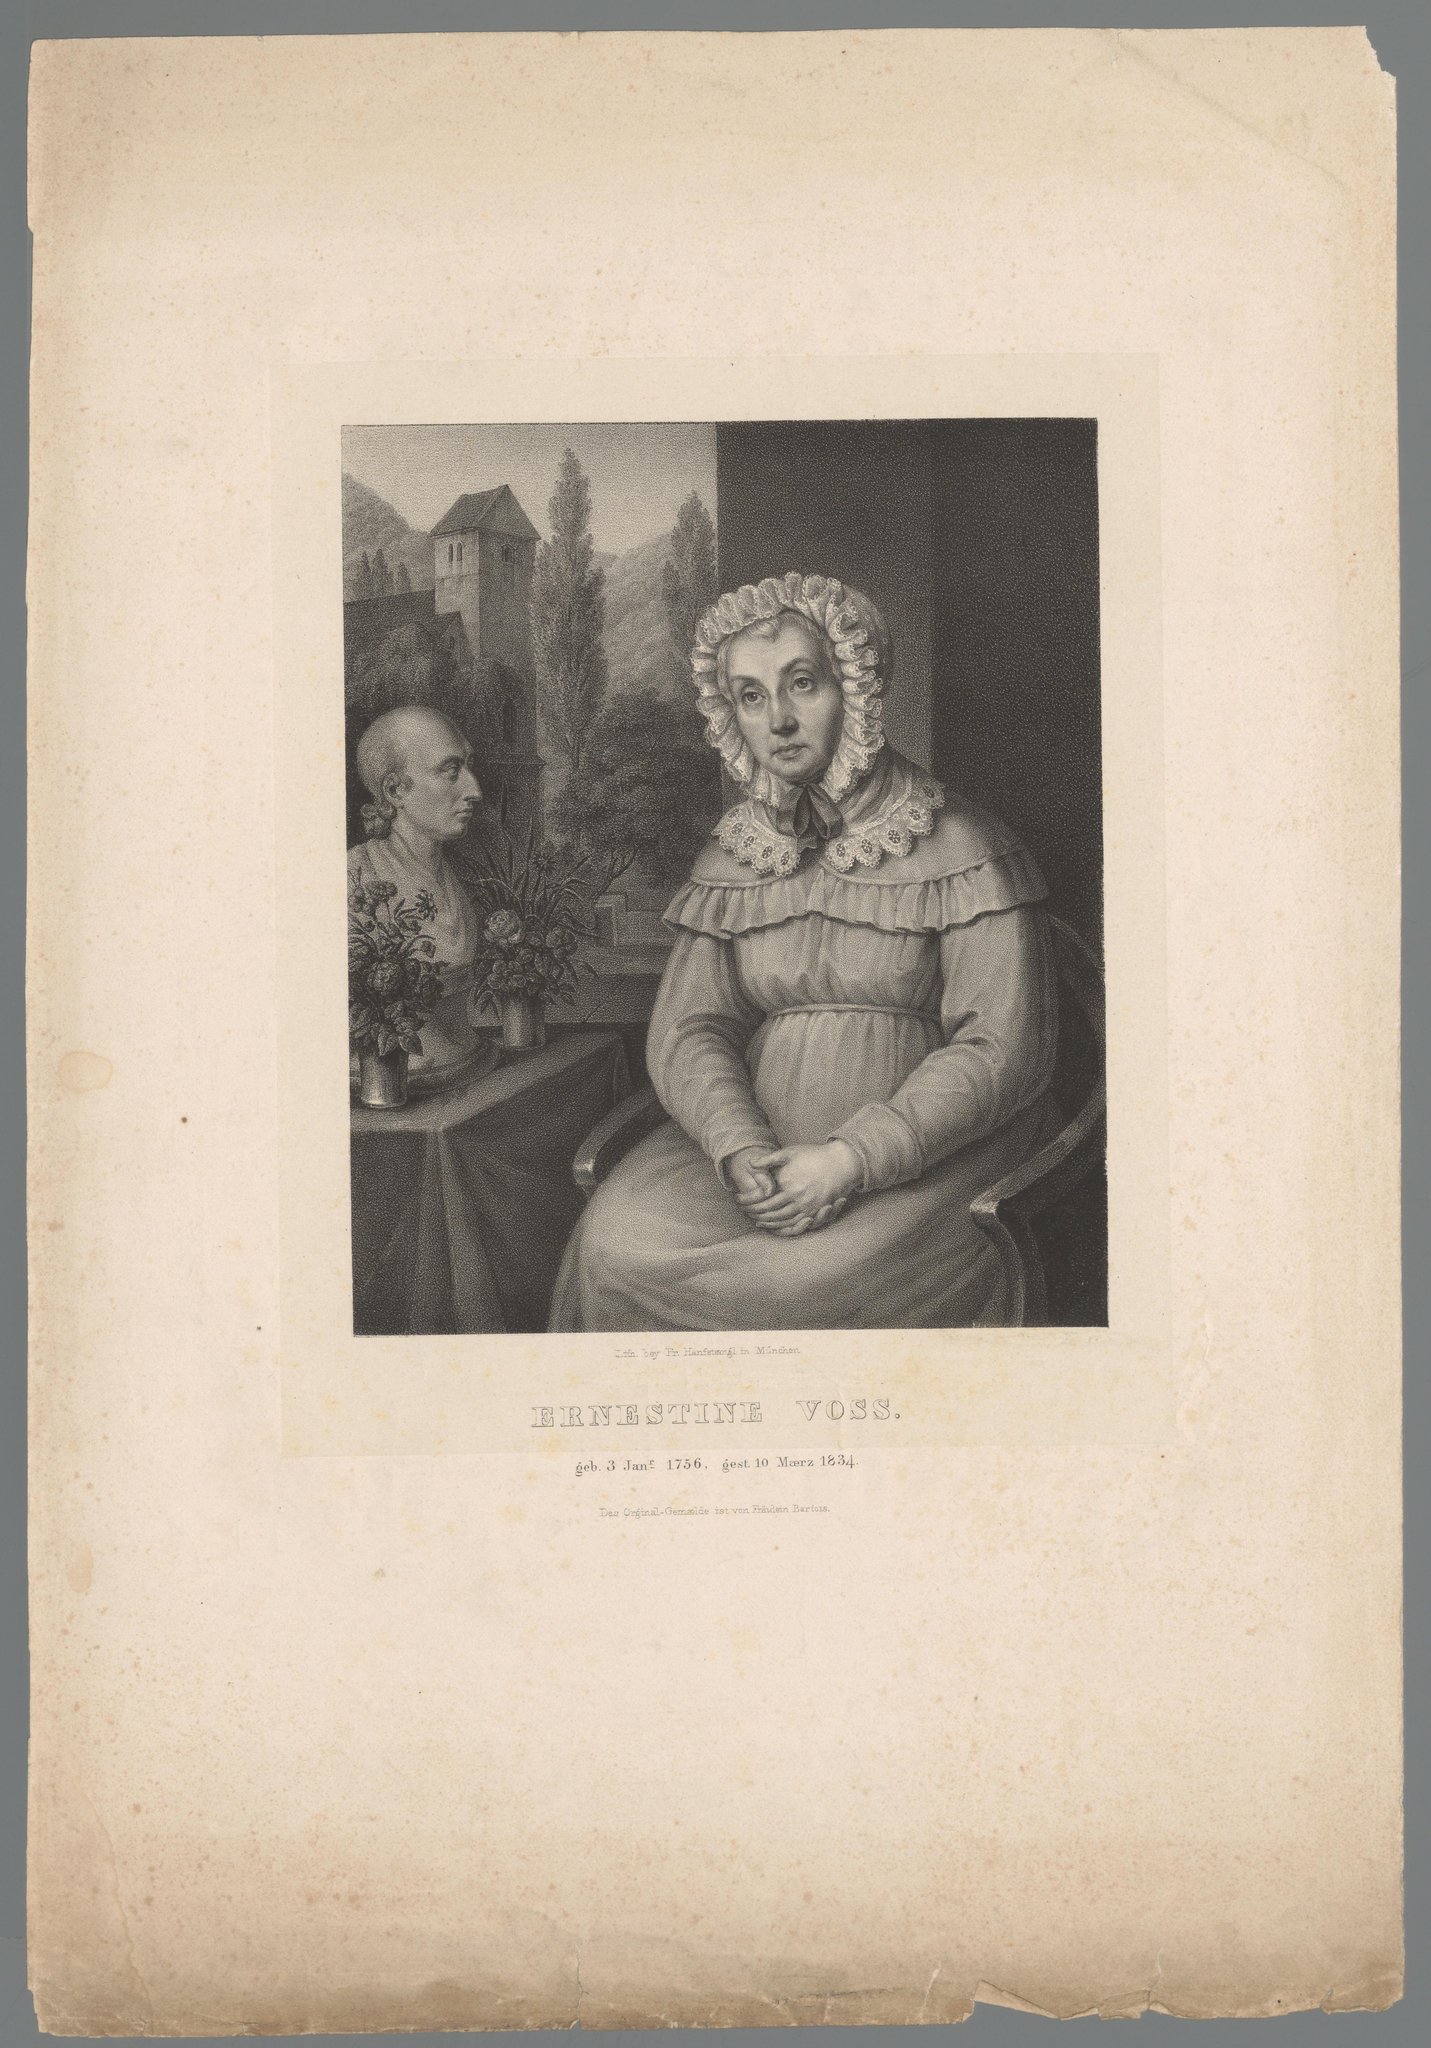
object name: print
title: Ernestine Voss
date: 1834-1877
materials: paper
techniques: lithograph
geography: munich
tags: adult woman, historical persons, piece of sculpture, reproduction of a piece of sculpture, hands folded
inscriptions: collector's mark: Lugt 2228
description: De buste links van Ernestine Voss is een portretbuste van haar man Johann Heinrich Voss.